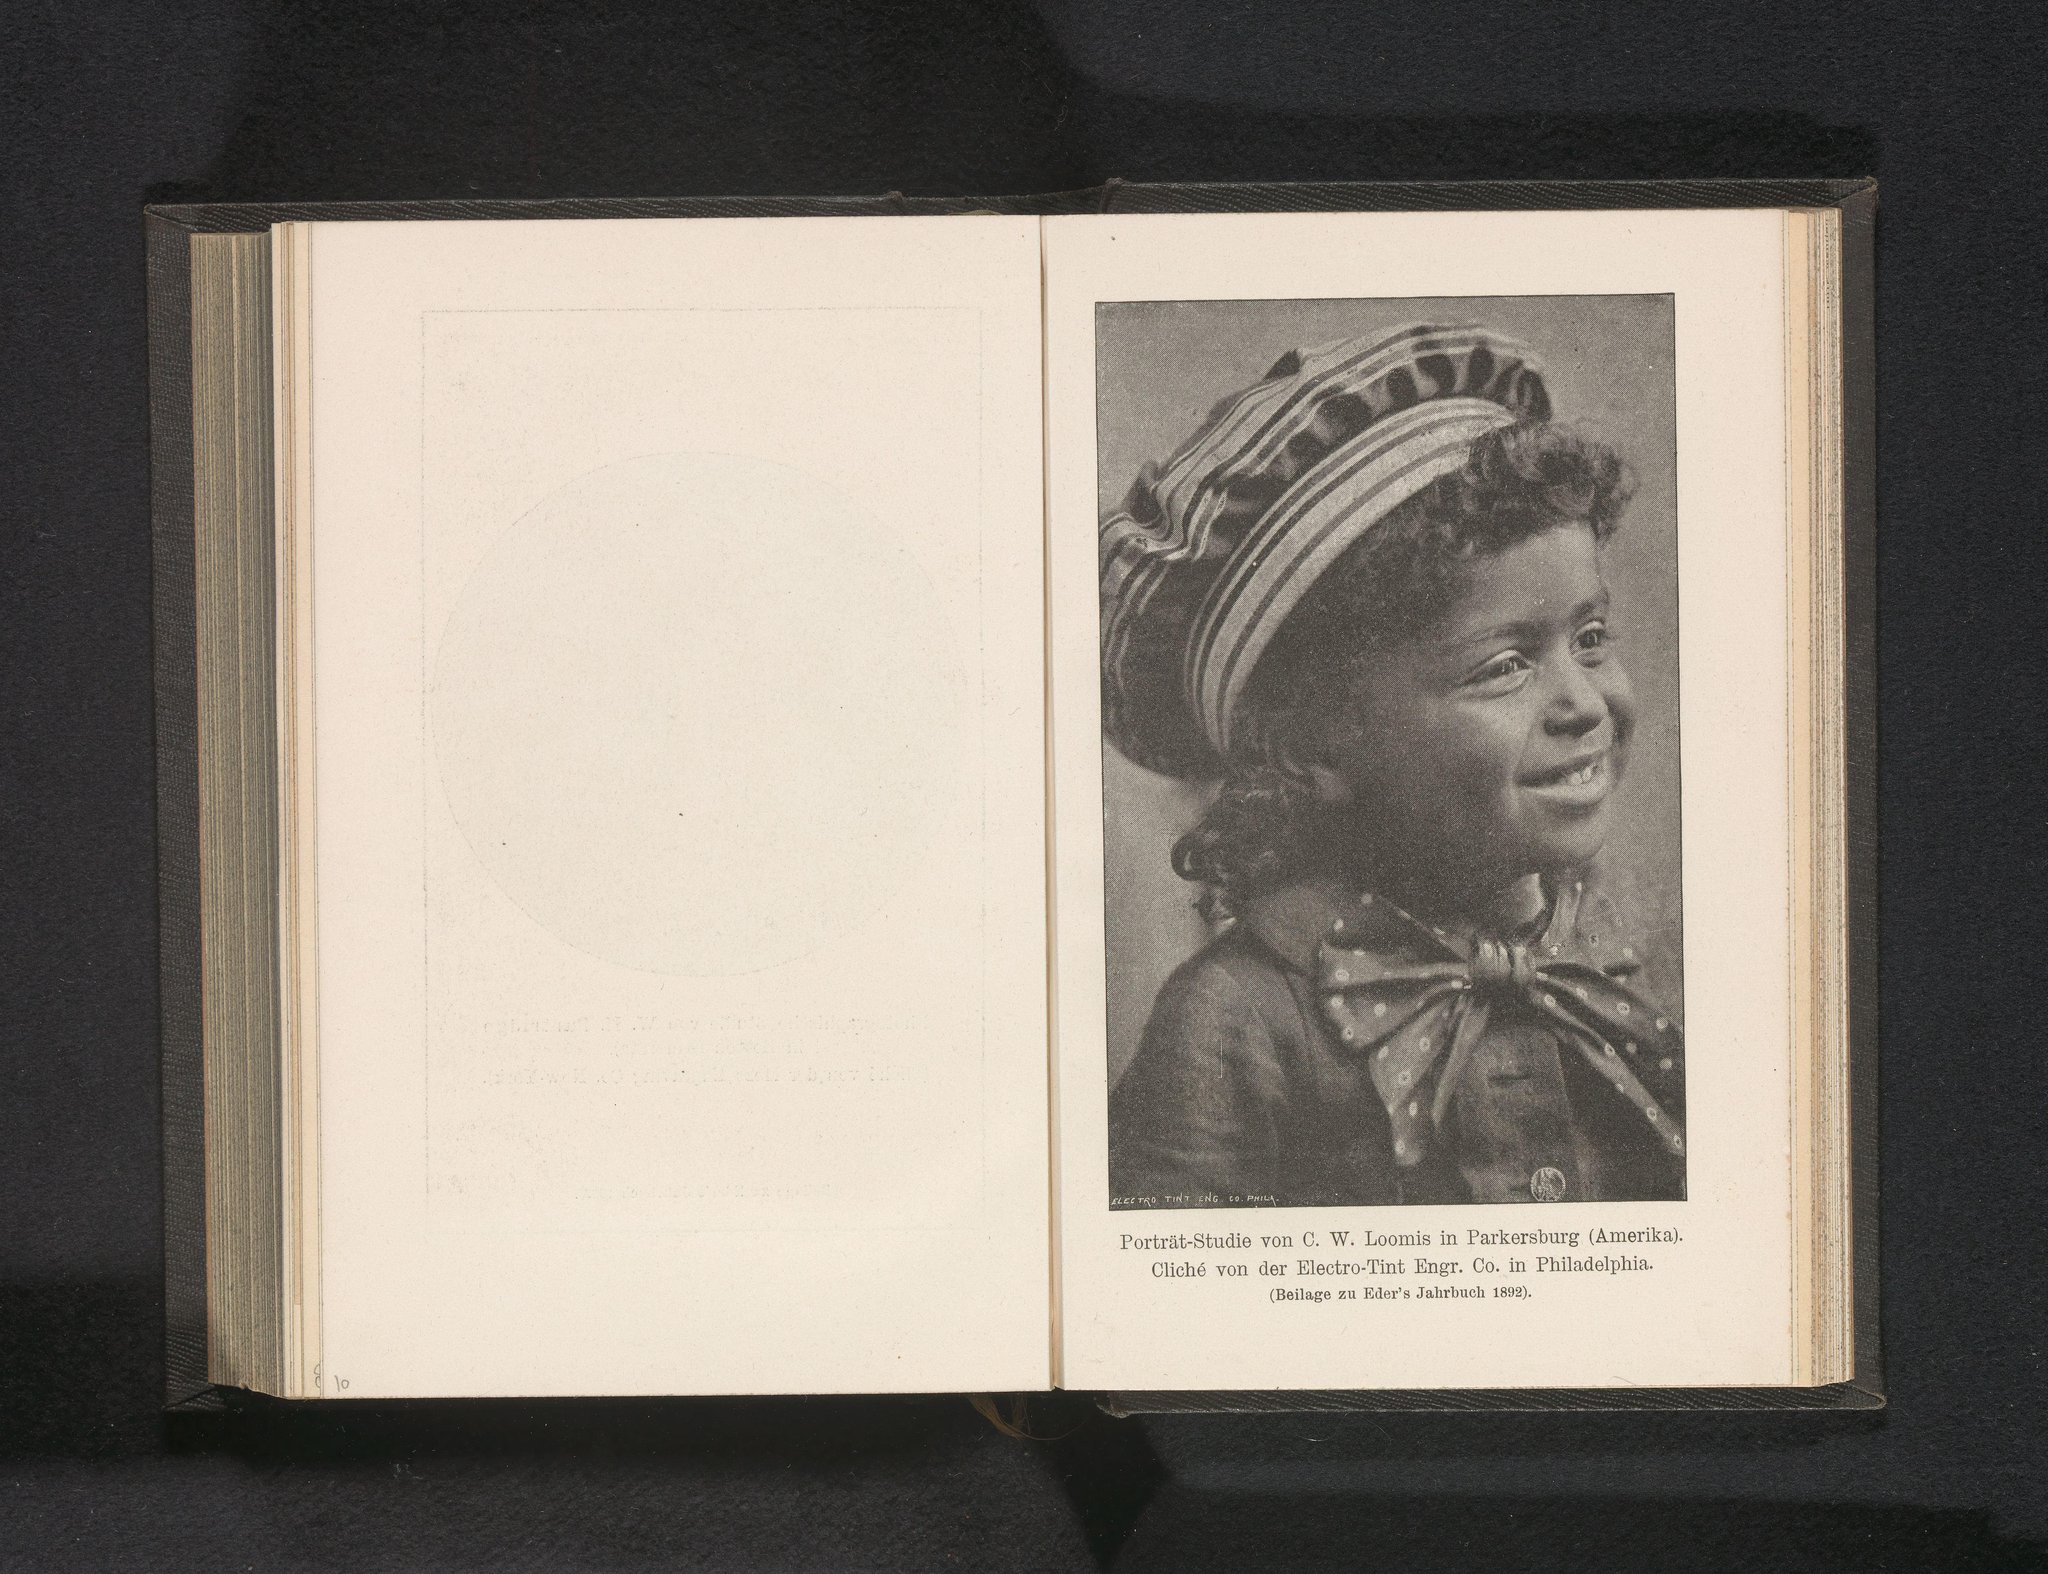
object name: page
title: Portretstudie van een onbekend meisje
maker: c.w. loomis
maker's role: fotograaf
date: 1887-1892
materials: paper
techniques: autotype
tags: historical persons - bb - woman, girl (child between toddler and youth)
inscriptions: inscription: ‘(Beilage zu Eder's Jahrbuch 1892).’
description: Prent op eenentwintigste ongenummerde pagina na pagina 520.